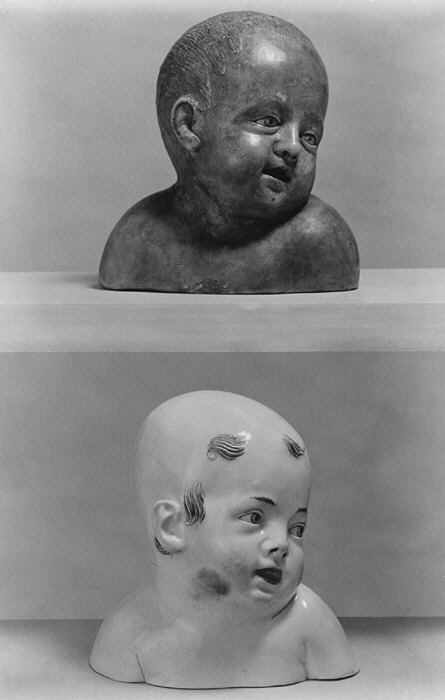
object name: bust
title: Child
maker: meissen manufactory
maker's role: manufactory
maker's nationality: german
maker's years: 1710-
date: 1715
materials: hard paste porcelain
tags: children